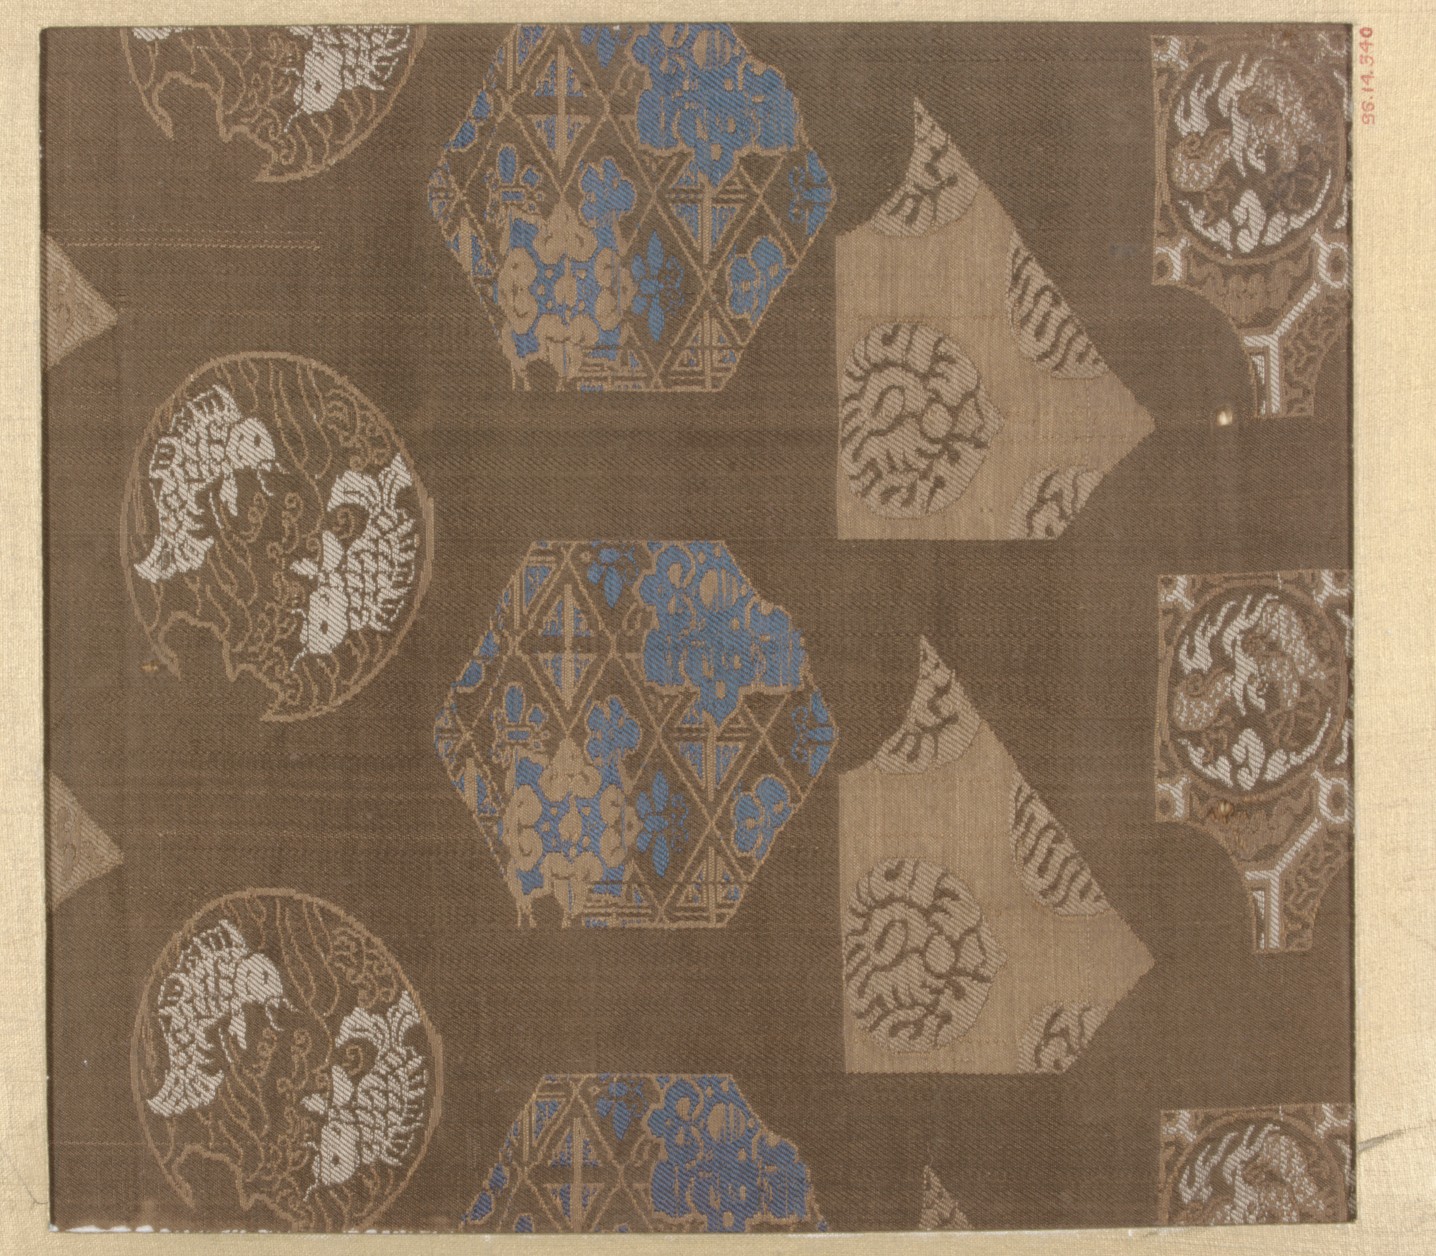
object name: piece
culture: japanese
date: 1701-1900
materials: silk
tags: fish